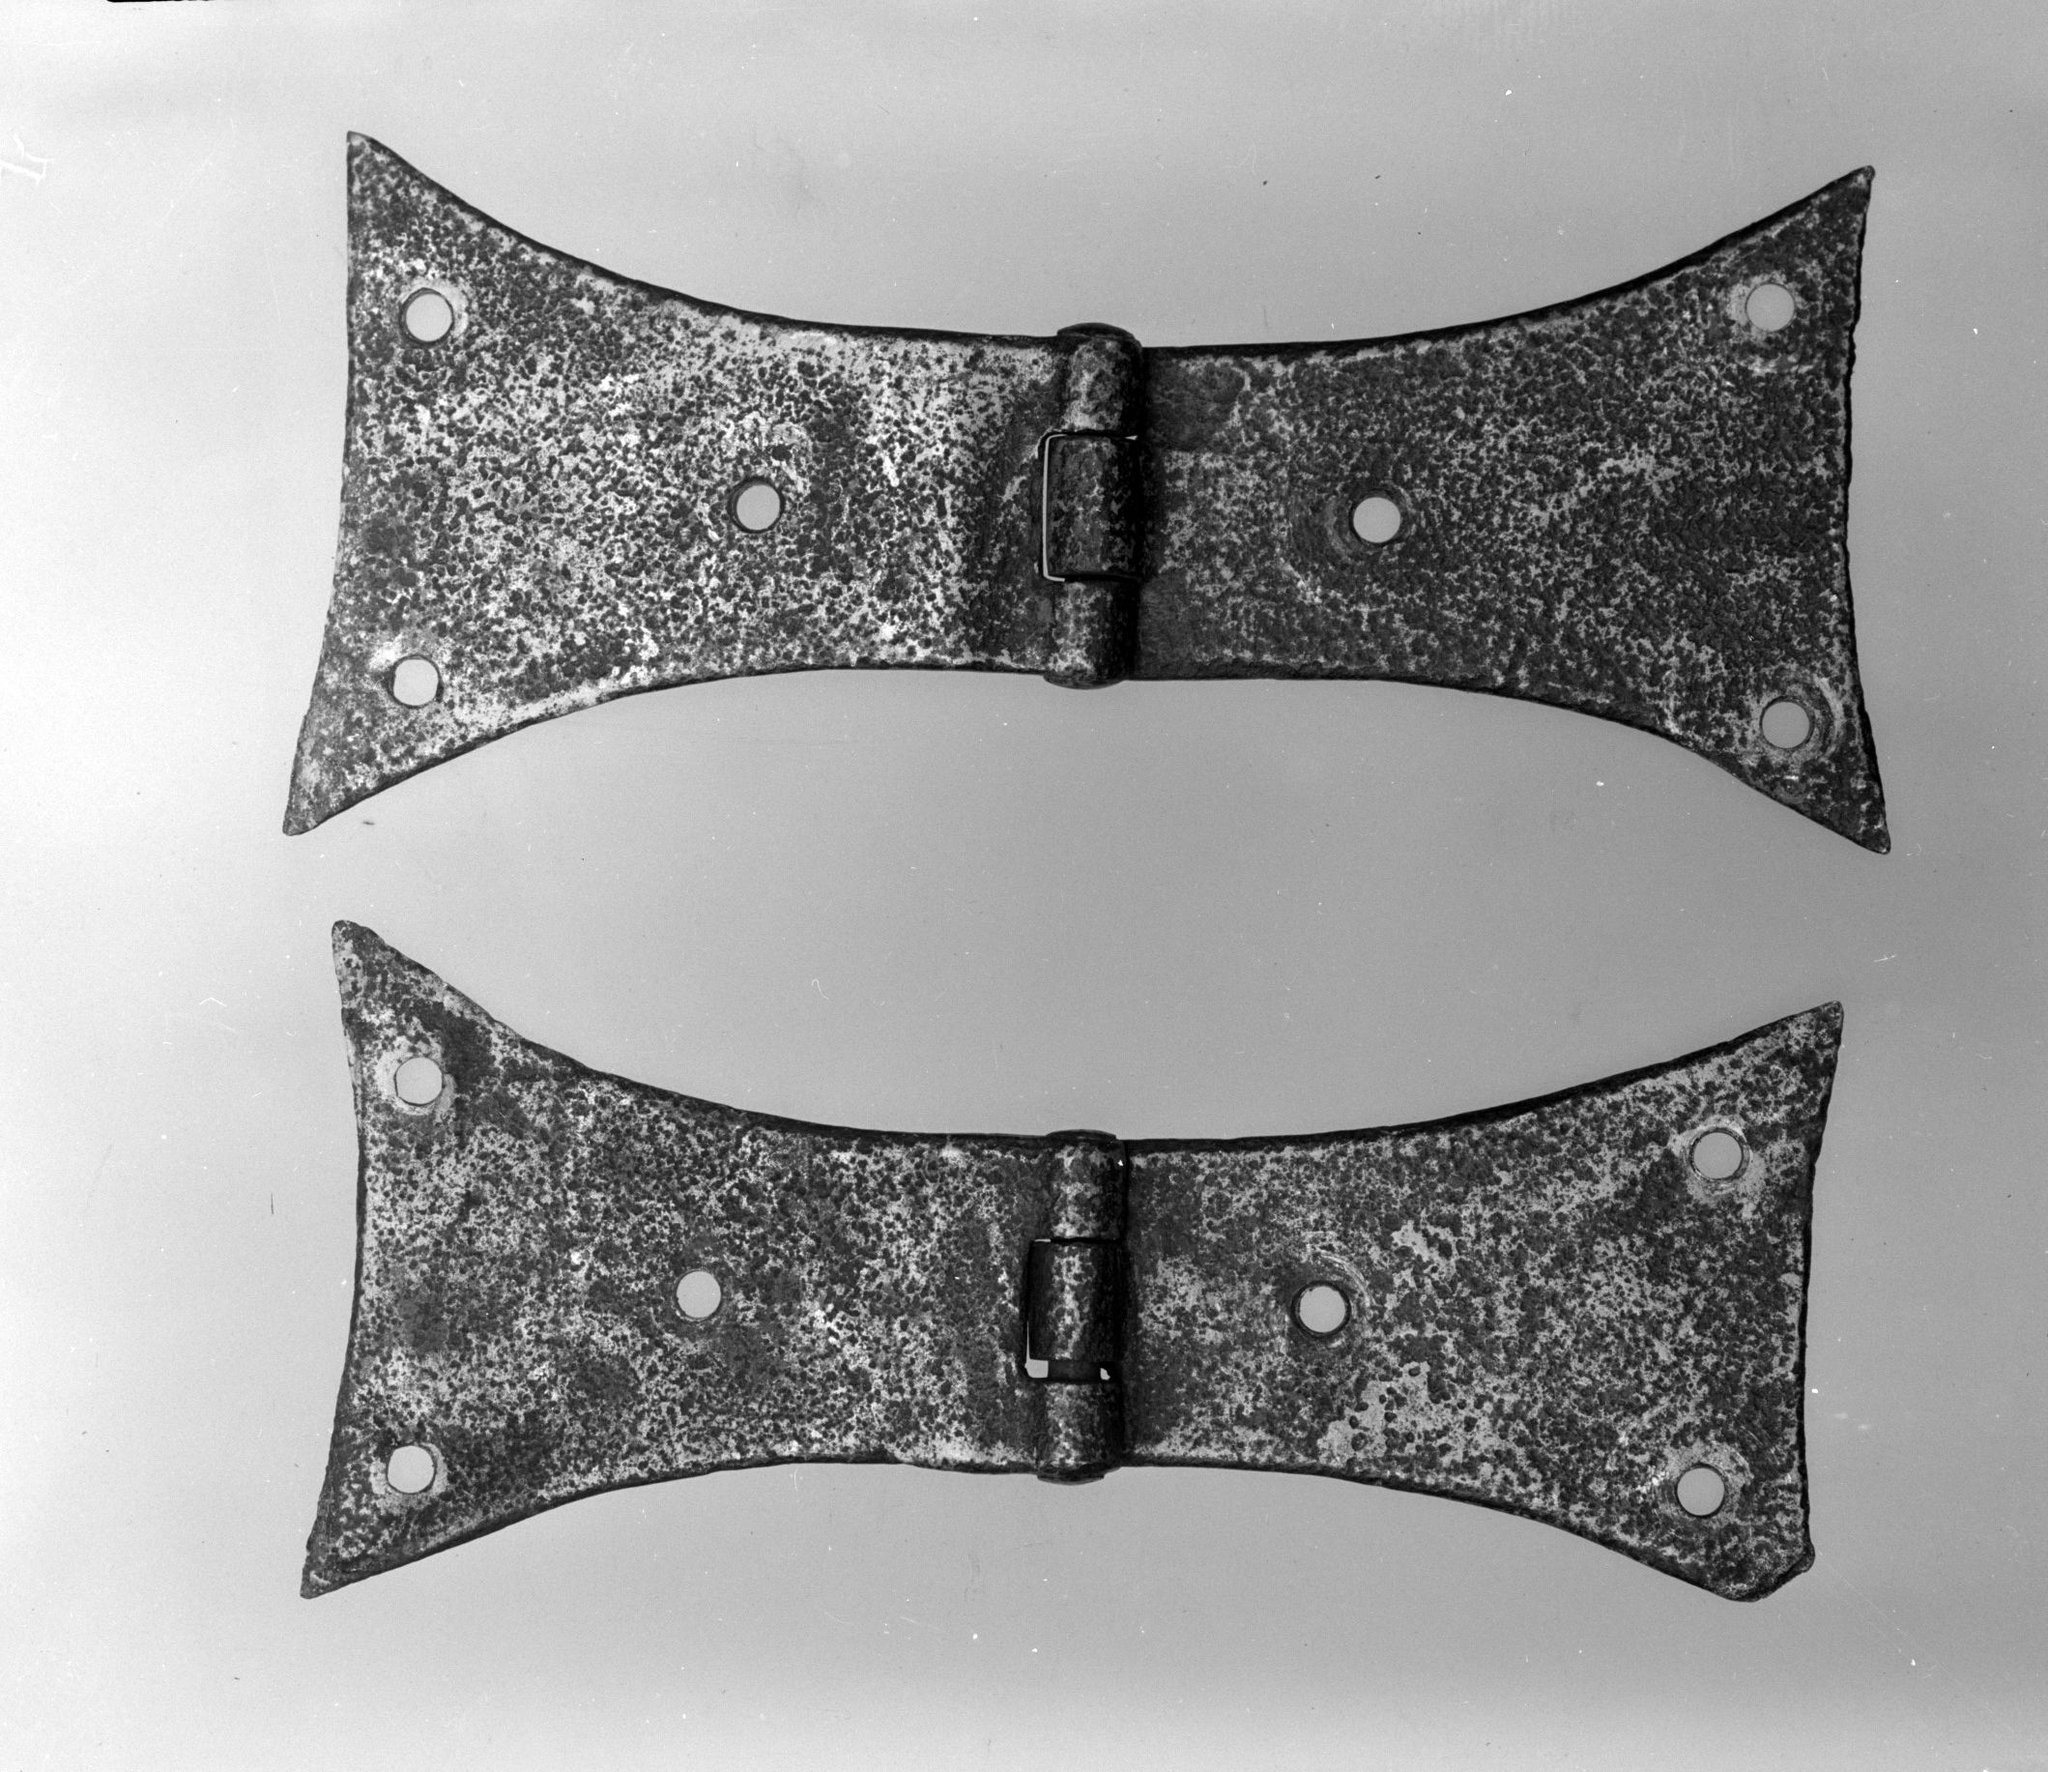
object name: hinge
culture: american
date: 1700-1800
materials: iron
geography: united states